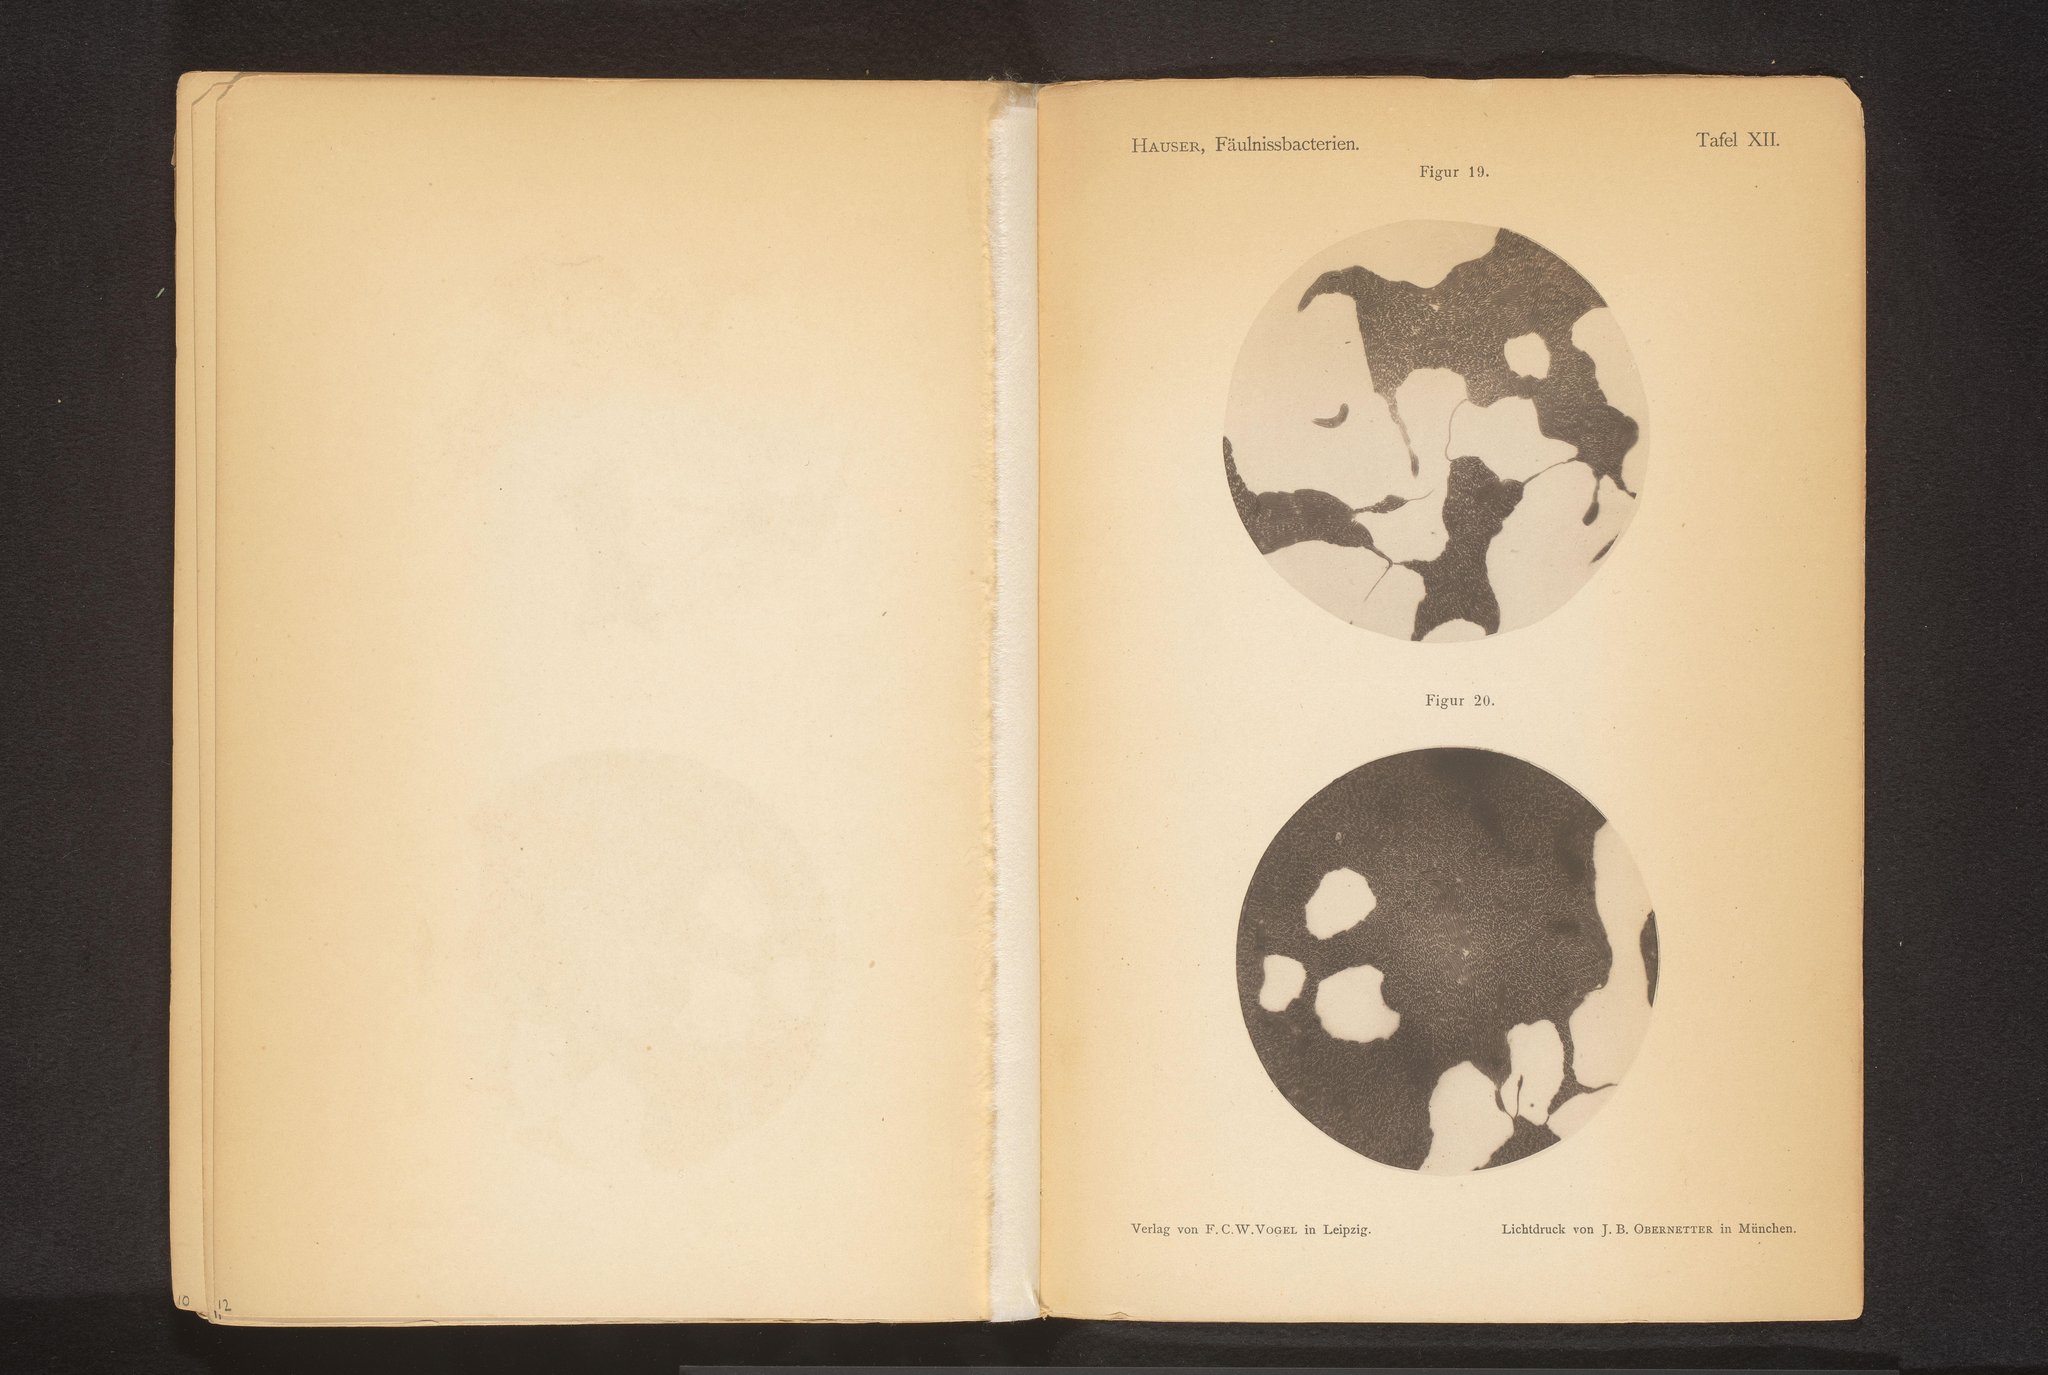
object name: photomechanical print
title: Twee microscoopopnamen van bederfbacteriën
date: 1875-1885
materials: paper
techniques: photograph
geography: munich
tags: unicellular animals, bacteria, bacilli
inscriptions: number: ‘Tafel XII. Figur 19. Figur 20.’